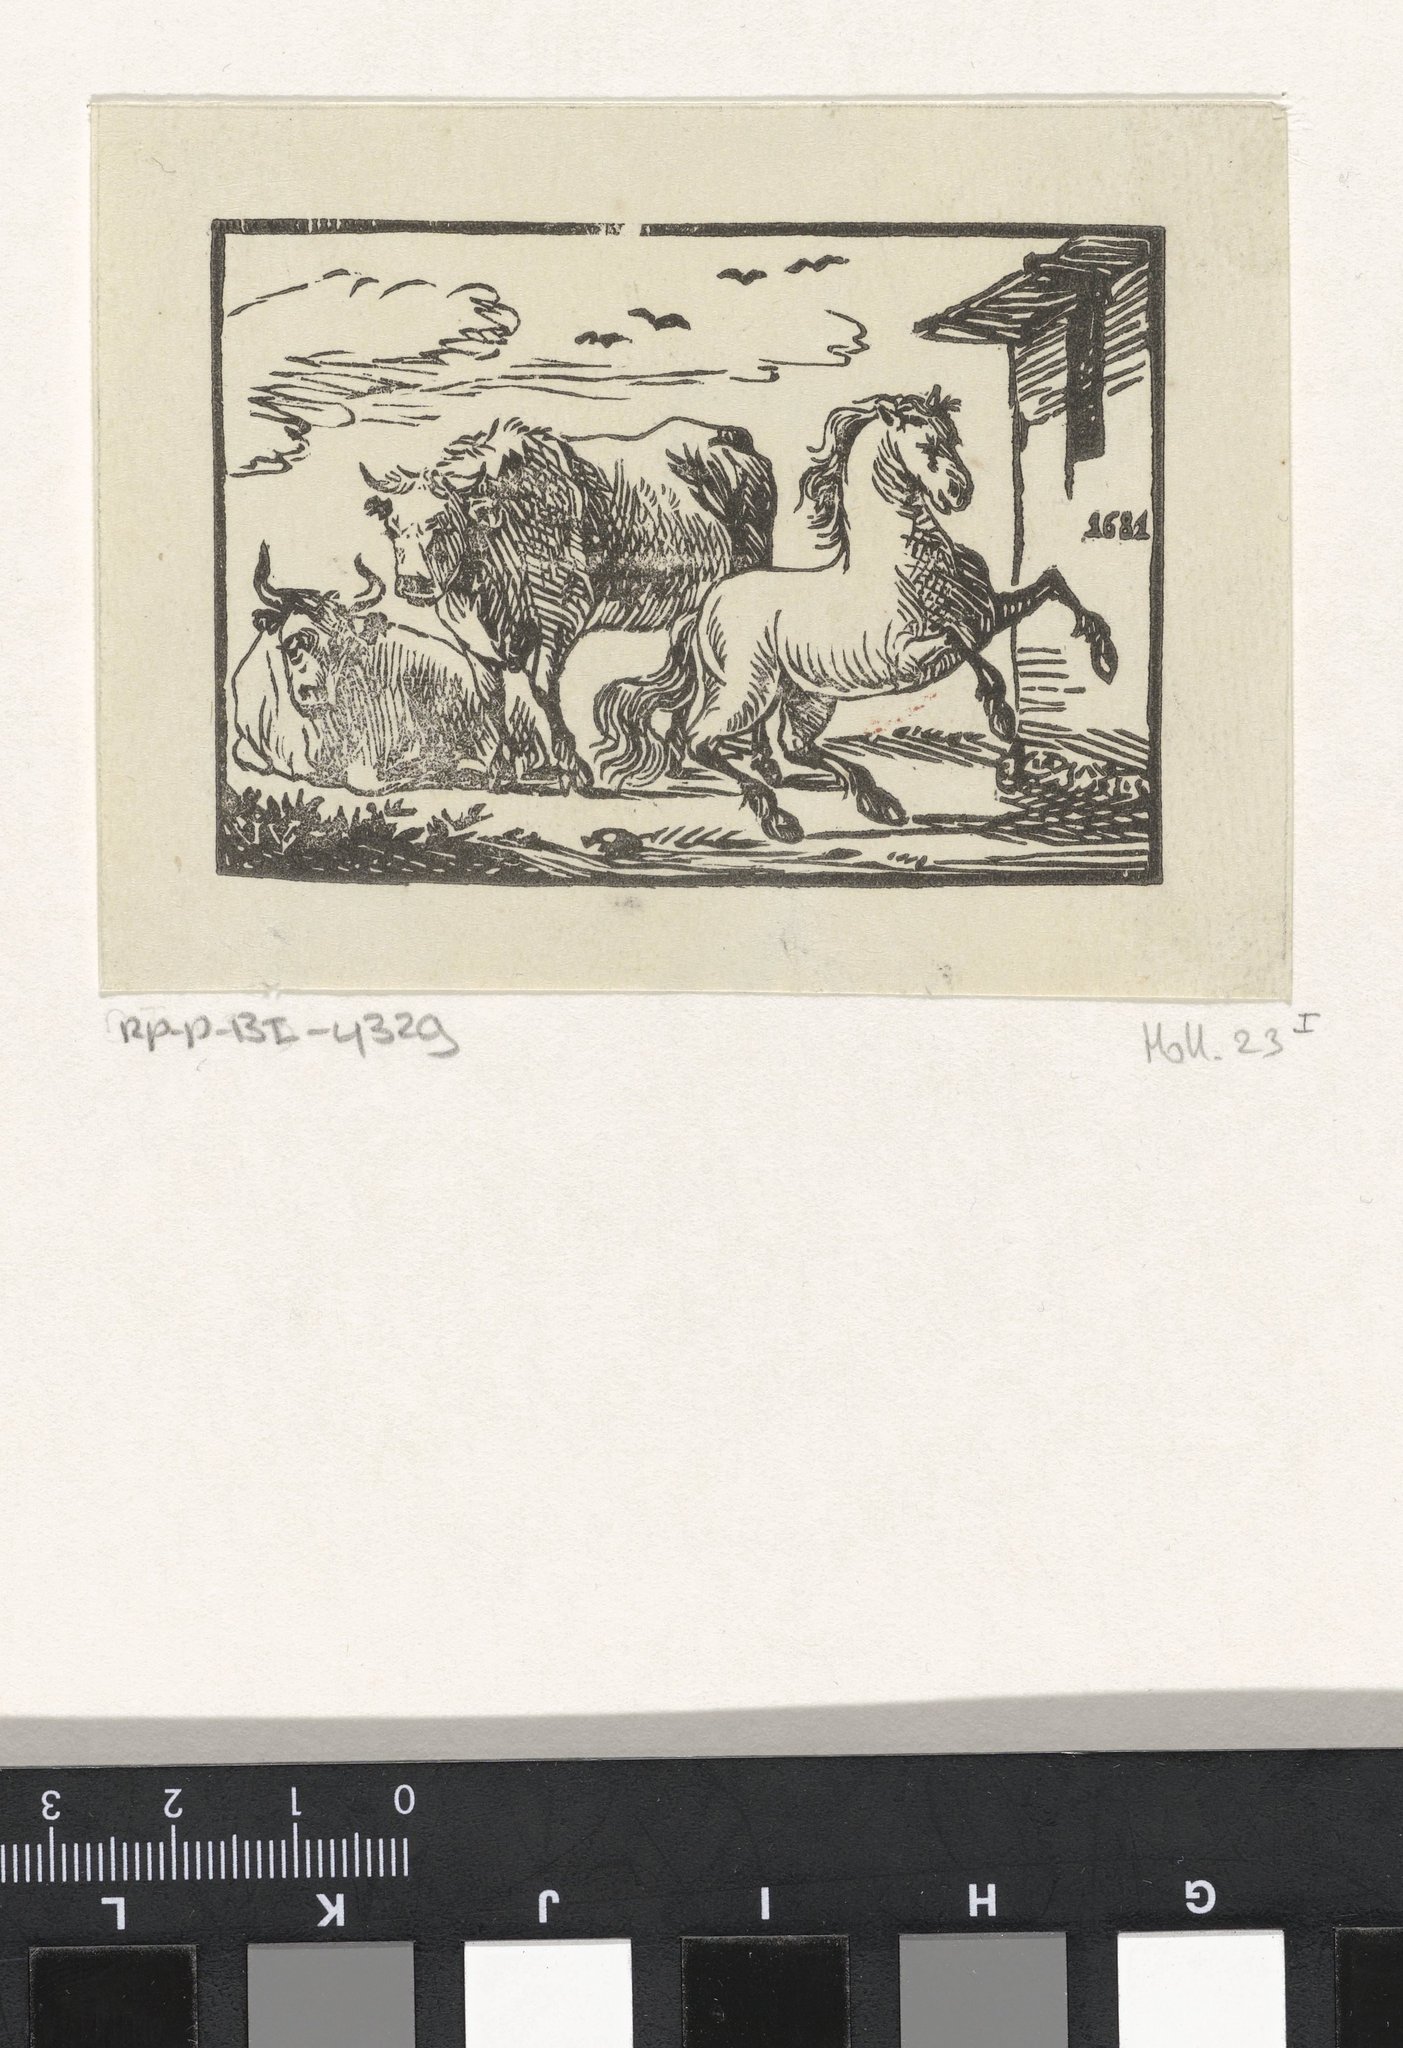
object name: print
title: Twee koeien en een steigerend paard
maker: isaac vincentsz. van der vinne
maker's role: draughtsman, print maker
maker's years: 1665-1740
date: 1681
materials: paper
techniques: woodcut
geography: haarlem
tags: cow, horse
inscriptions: collector's mark: Lugt 240